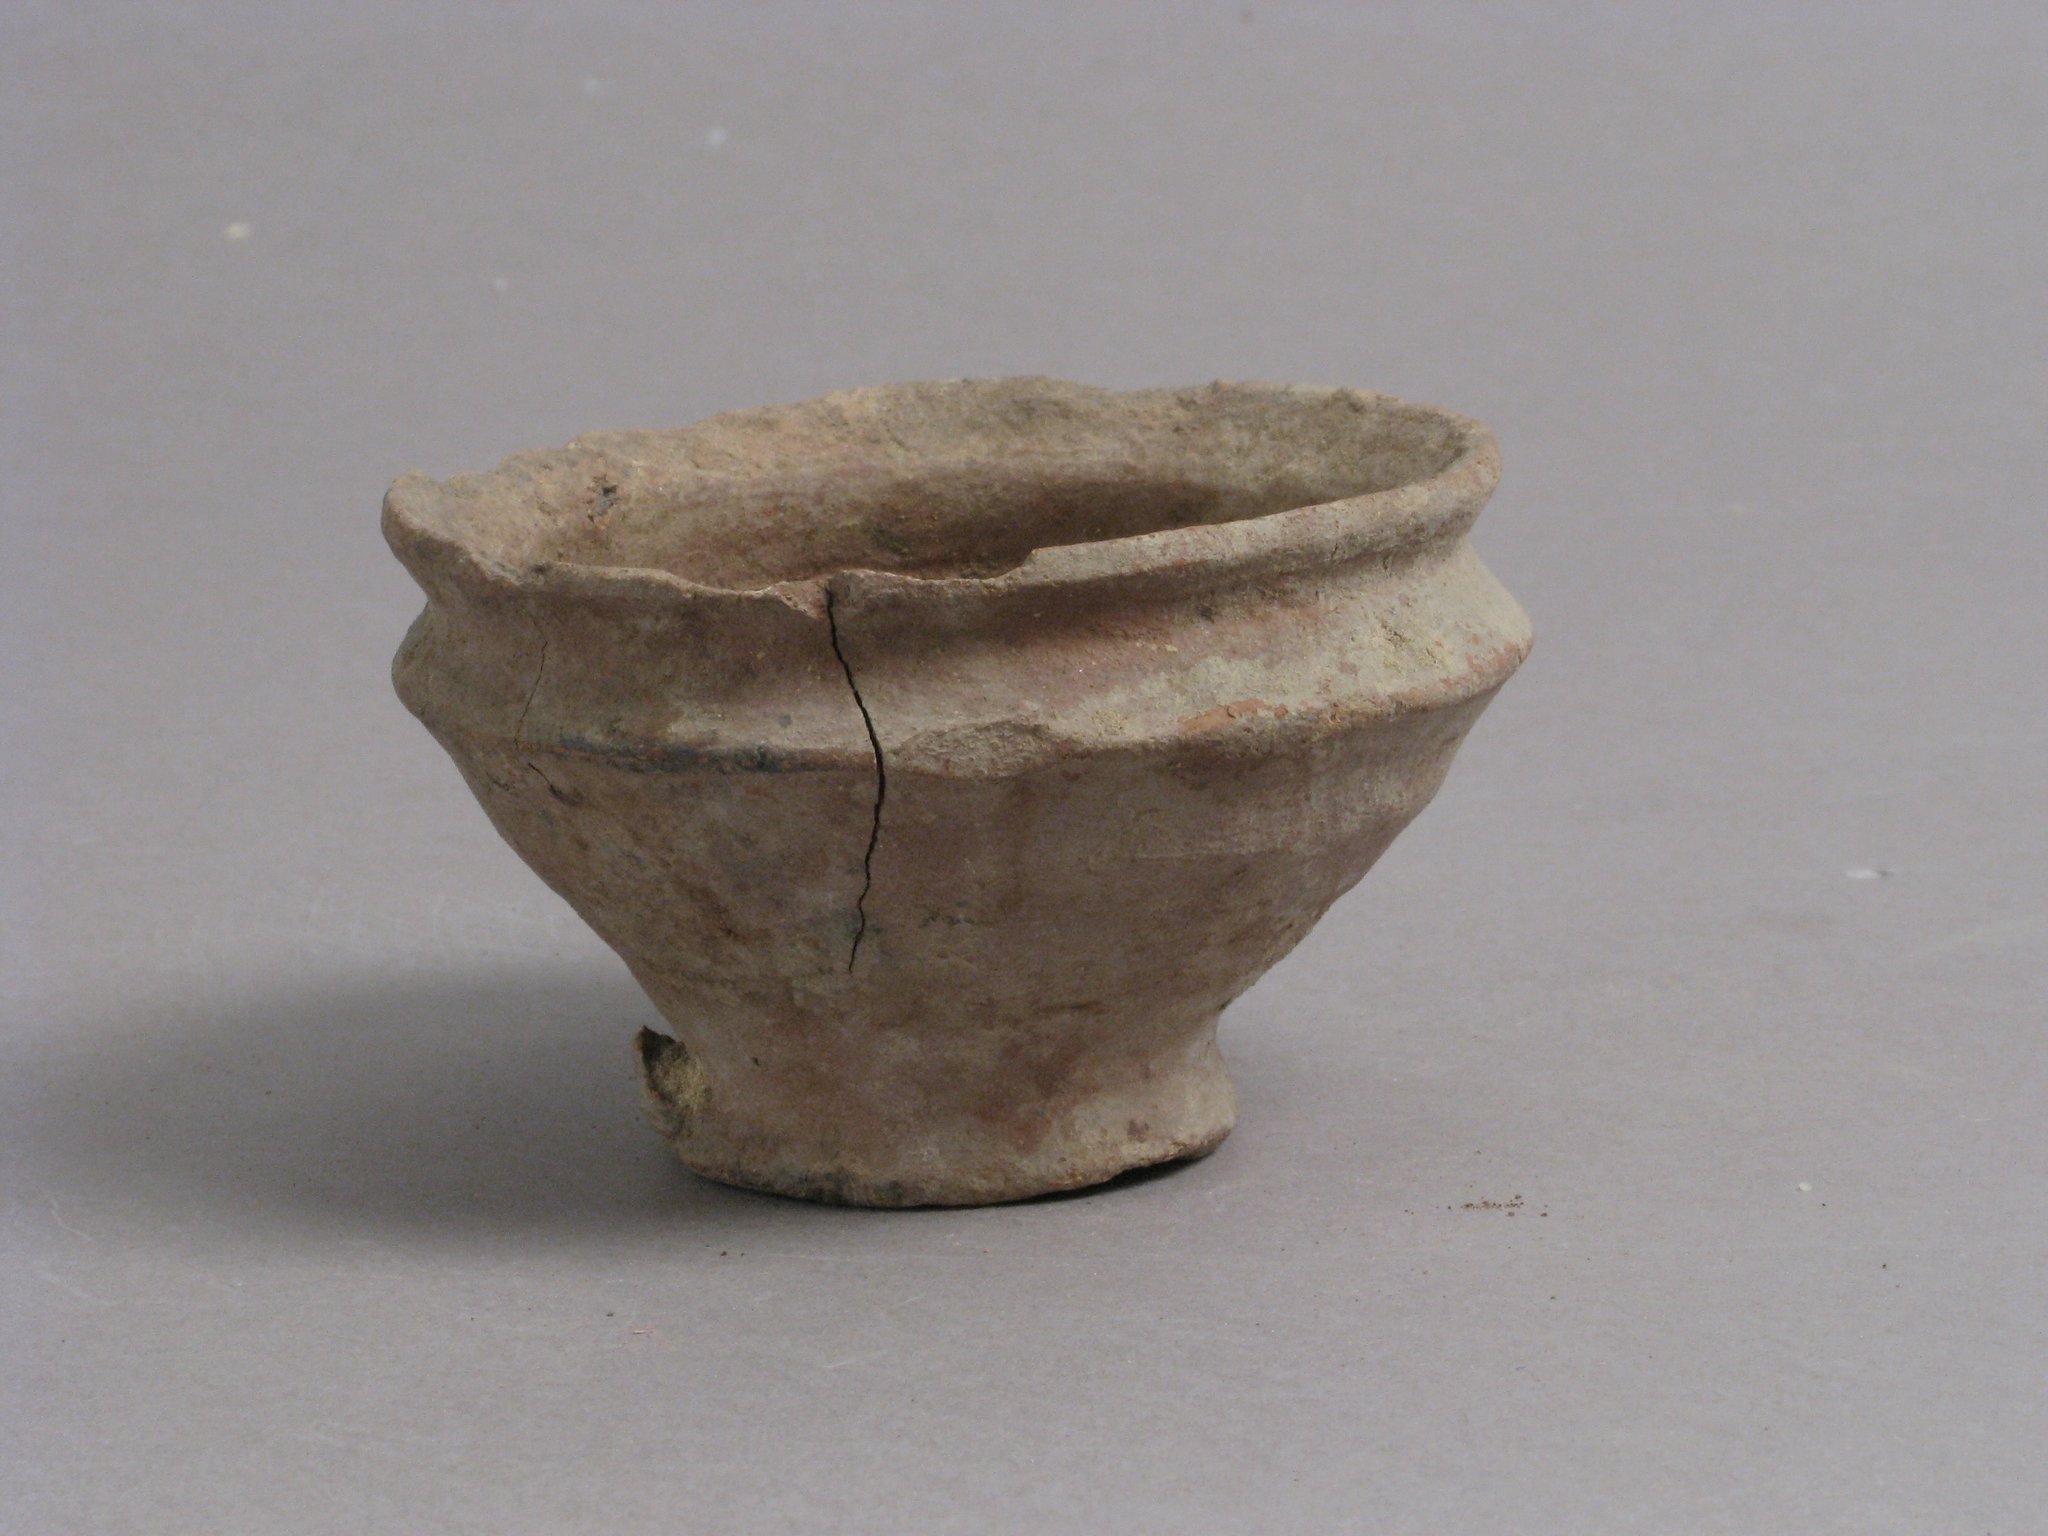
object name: bowl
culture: coptic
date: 301-700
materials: earthenware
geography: egypt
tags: bowls